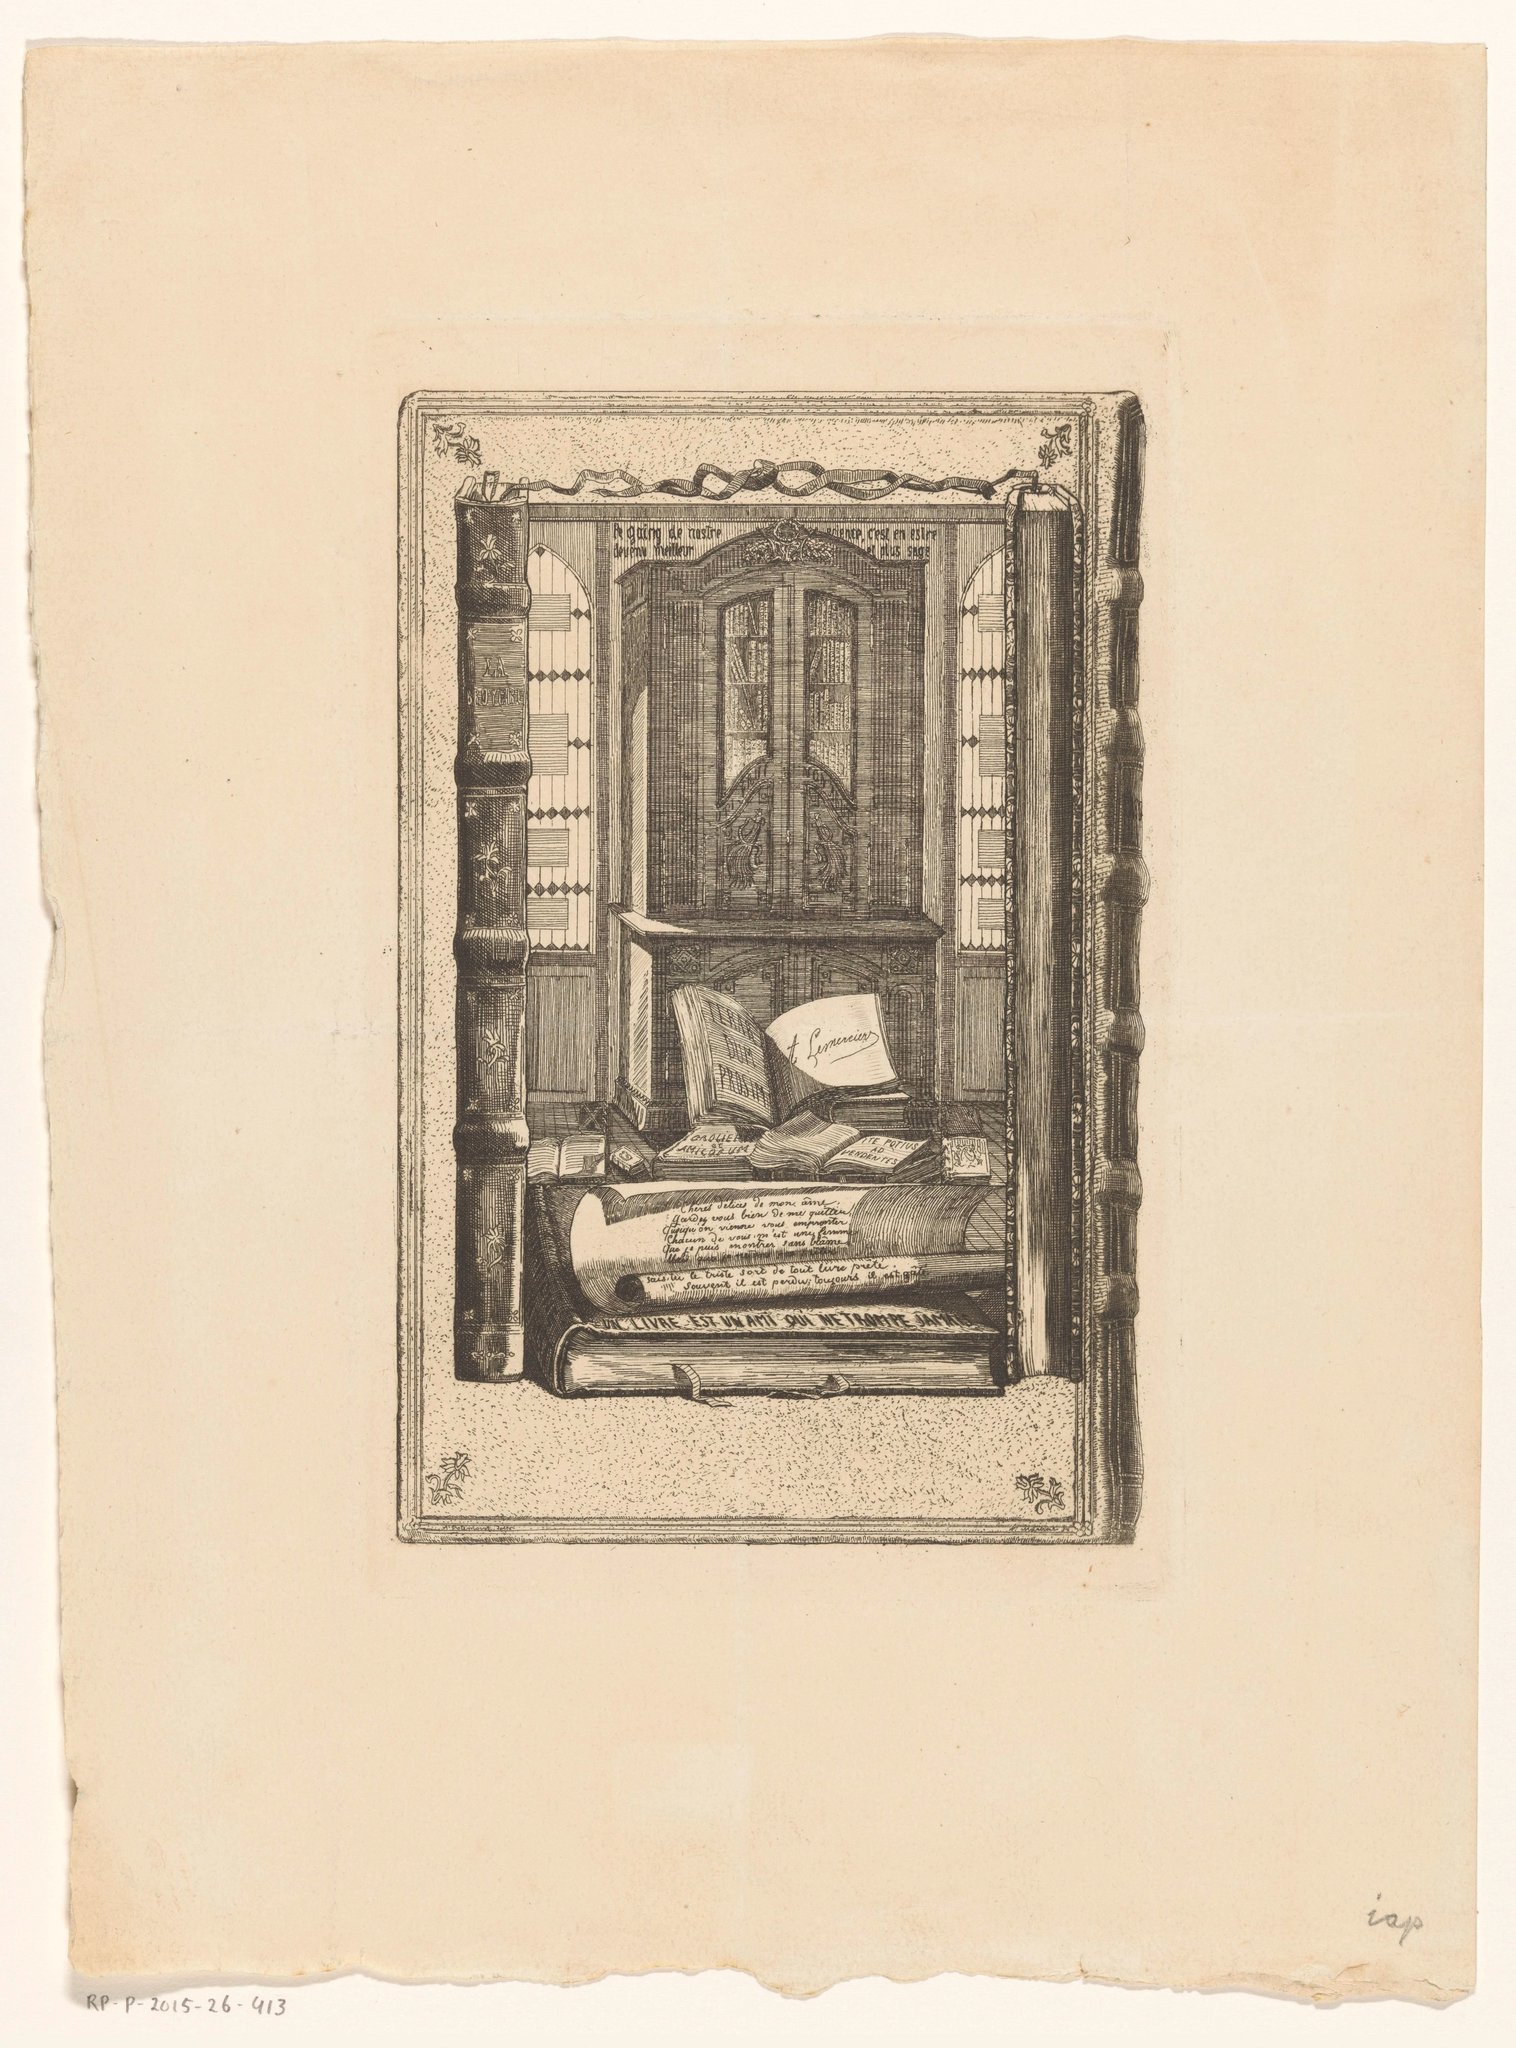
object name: print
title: Compositie met boeken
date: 1838-1883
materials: paper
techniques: etching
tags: bookbinding, bookshelves, book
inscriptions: collector's mark: Lugt 2228, collector's mark: Lugt 4779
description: Voorstelling op de achterzijde van een gedecoreerde leren boekband, bestaande uit een boekenkast gedecoreerd met houtsnijwerk, op de voorgrond enkele boeken en een beschreven vel, aan weerszijden staande boeken, een op de rug gezien, de ander op de snede.